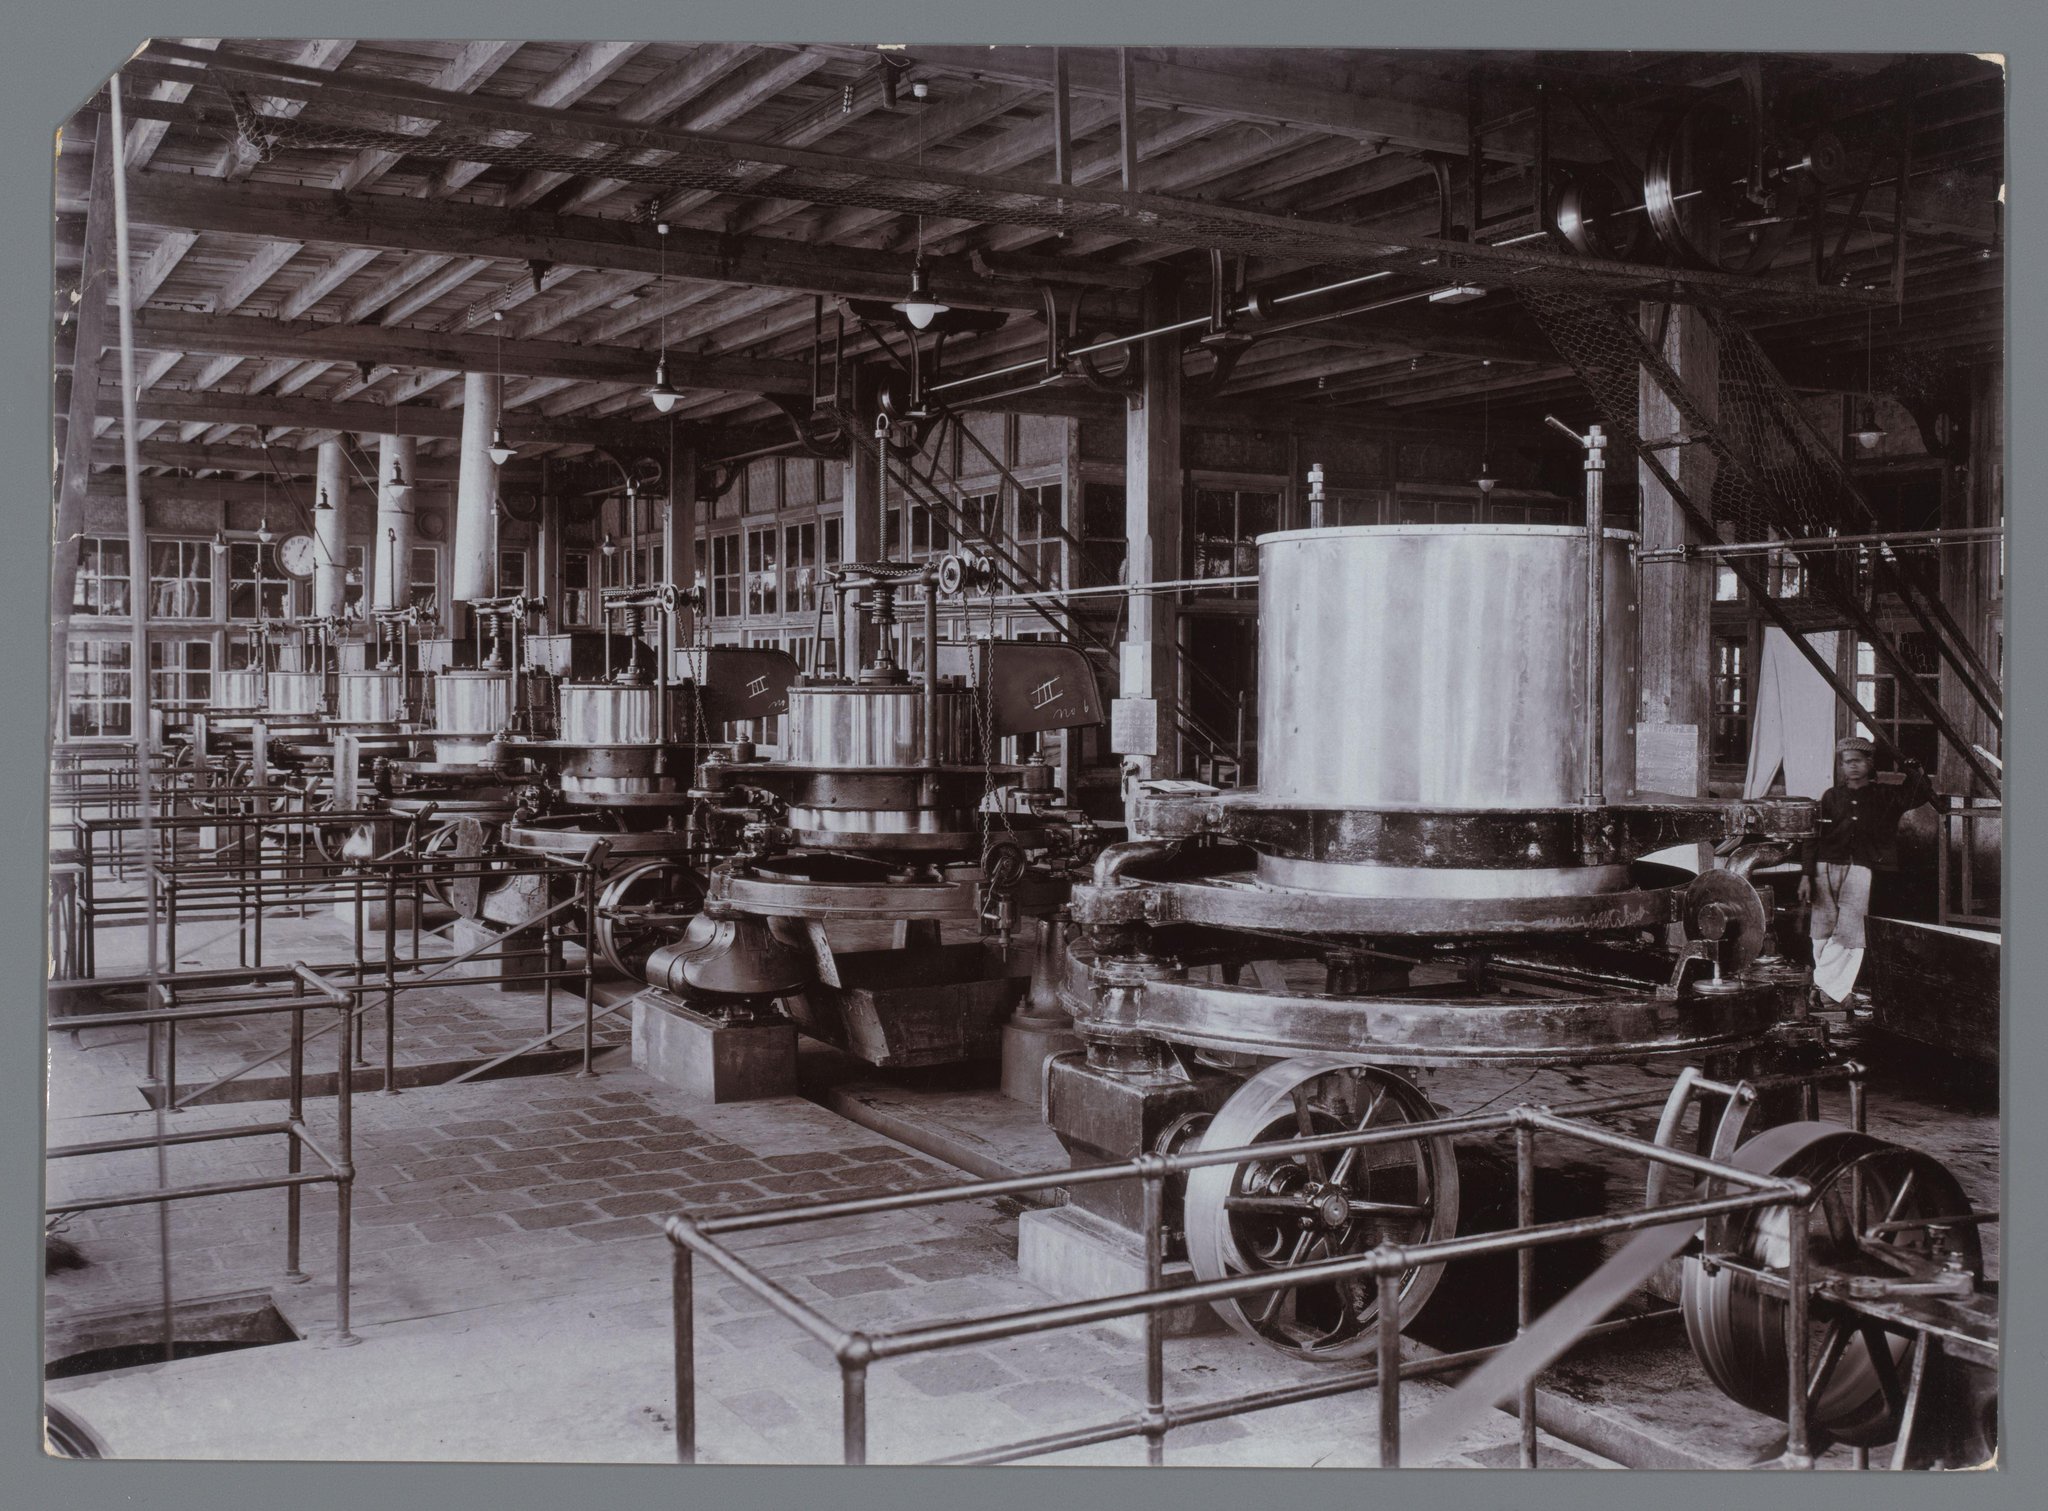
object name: photograph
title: Toproller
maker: Anonymous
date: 1931-1937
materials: photographic support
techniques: gelatin silver print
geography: java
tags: colonial system, factory-interior, machine shop, machines; parts of machines; tools and appliances, (non-fruit) products of plants or trees (with name), tea (leaves), java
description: Fabriekshal met toprollers in de theefabriek Sinumbra op Java. Onderdeel van de multomap met foto's van machines van de N.V. Machinefabriek Braat te Soerabaja en Soekaboemi bestemd voor de Nederlandse theeindustrie op Java en Sumatra, uit de periode 1931-1937.